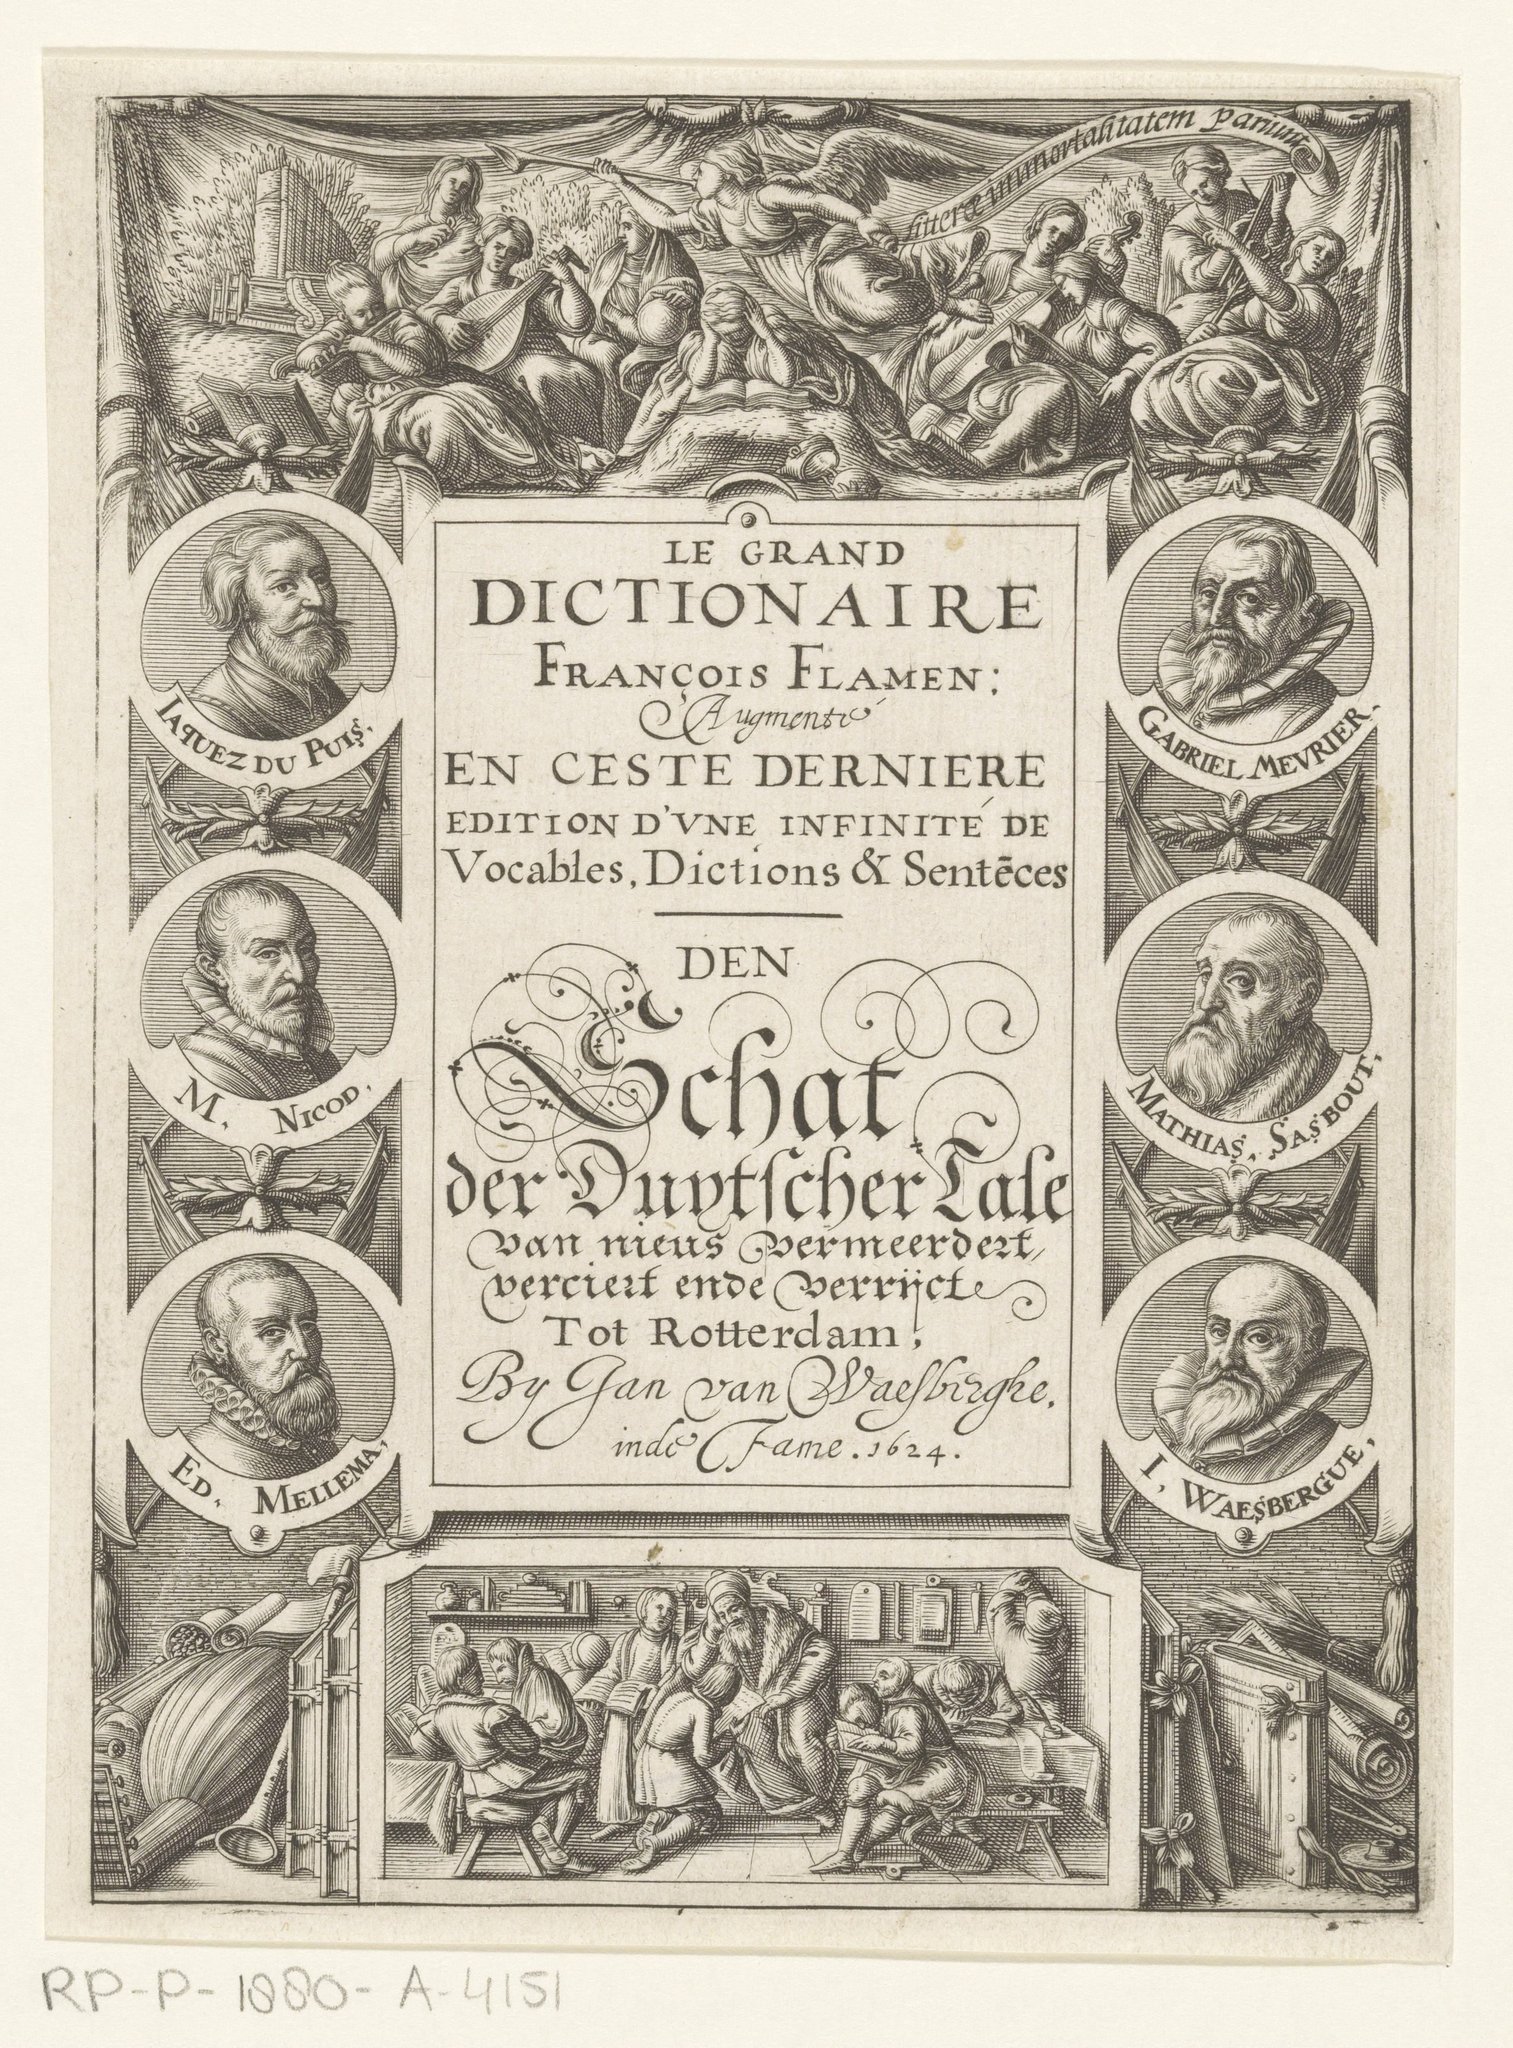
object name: print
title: Portretten van woordenboekuitgevers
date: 1624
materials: paper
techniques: engraving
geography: rotterdam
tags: publishing, publisher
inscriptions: collector's mark: Lugt 2228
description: Zes portretten van woordenboekuitgevers Jaques du Pius, M. Nicod, Ed. Mellema, Gabriel Meurier, Mathias Sarbout en Jan van Waesberge flankeren de titel. Aan de bovenzijde een groep musicerende vrouwen. Aan de onderzijde een oude man te midden van lezende figuren in een leeszaal. Links en rechts muziekinstrumenten en schrijfgerei.